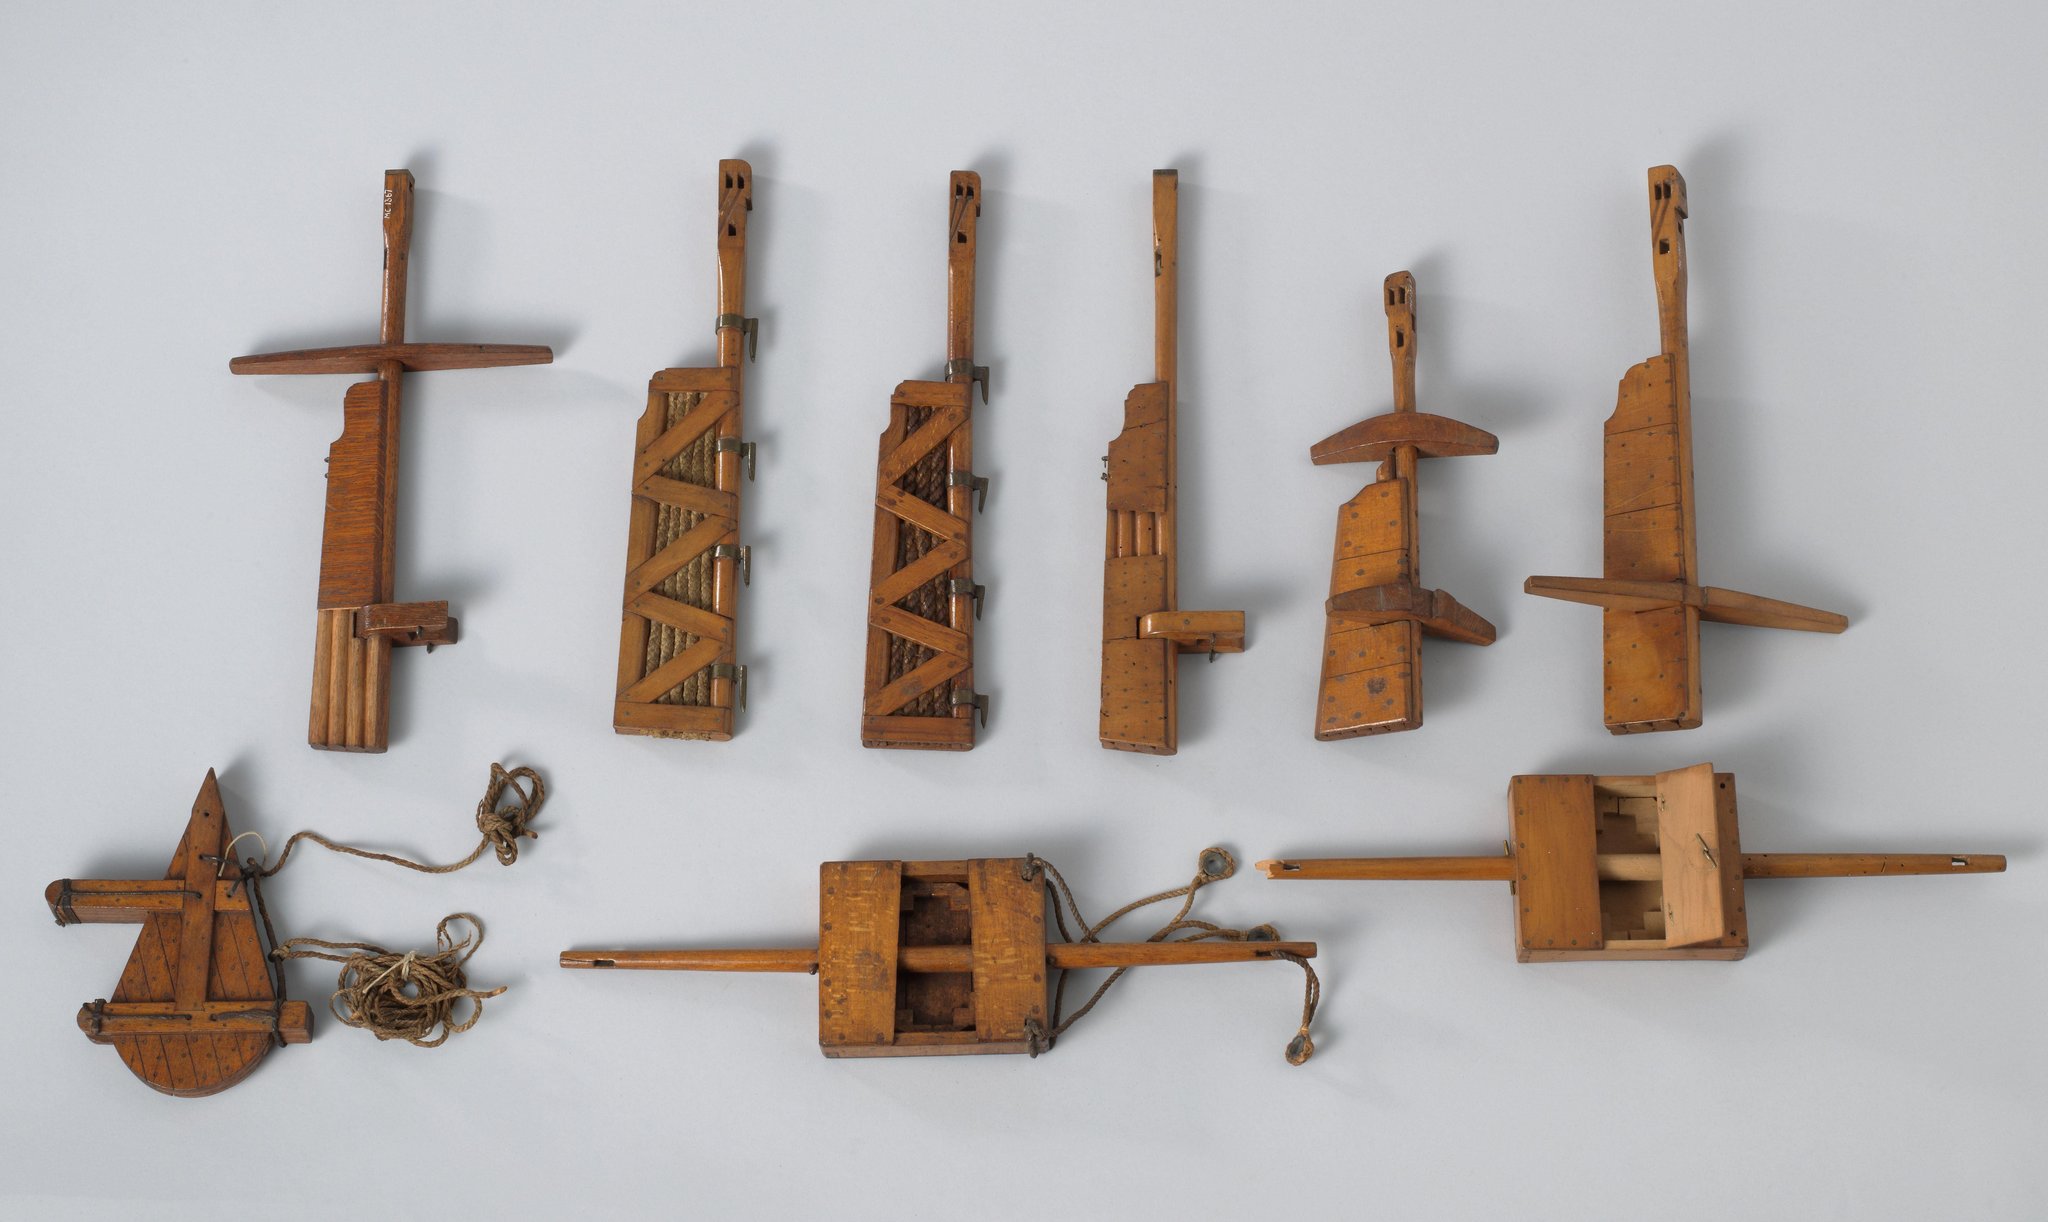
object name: demonstration model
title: Model of a Jury Rudder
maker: Anonymous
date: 1820-1870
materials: fiber, wood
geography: netherlands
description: Negen modellen van noodroeren. Drie noodroeren (nrs. 1-3) zijn bijna identiek aan de modellen NG-MC-228, 229 en 230. Ze hebben een steng als roerkoning en het roerblad is samengesteld uit rondhouten met planken bedekt. Twee daarvan (nrs. 1-2) hebben een ezelshoofd als roerhaak om de koning, bij de derde is hiervoor een ankerstok gebruikt. Eén noodroer (nr. 2) heeft een ankerstok om de roerkop, vergelijkbaar met model NG-MC-229 (Pakenhams noodroer). Het vierde model is een kleinere versie van dit type noodroer en heeft twee korte ankerstokken om de koning, een als roerhaak en een om de roerkop. Twee bijna identieke modellen (nrs. 5-6) zijn noodroeren met een steng als roerkoning en het roerblad is samengesteld uit trossen die door planken bijeen worden gehouden; deze modellen hebben speciale messing roerhaken. Het zevende model, van planken gemaakt, heeft een druppelvorm en is vermoedelijk gebaseerd op het ontwerp van Bassiere. Het laatste paar modellen (nrs. 8-9) bestaat uit een ra waar een kast omheen is gebouwd. De hoeken van de kast zijn aan de binnenkant verstevigd met de wangen van rolpaarden. Eén model (nr. 8) is voorzien van stroppen aan één kant, vermoedelijk voor de bevestiging van stuurtalies.